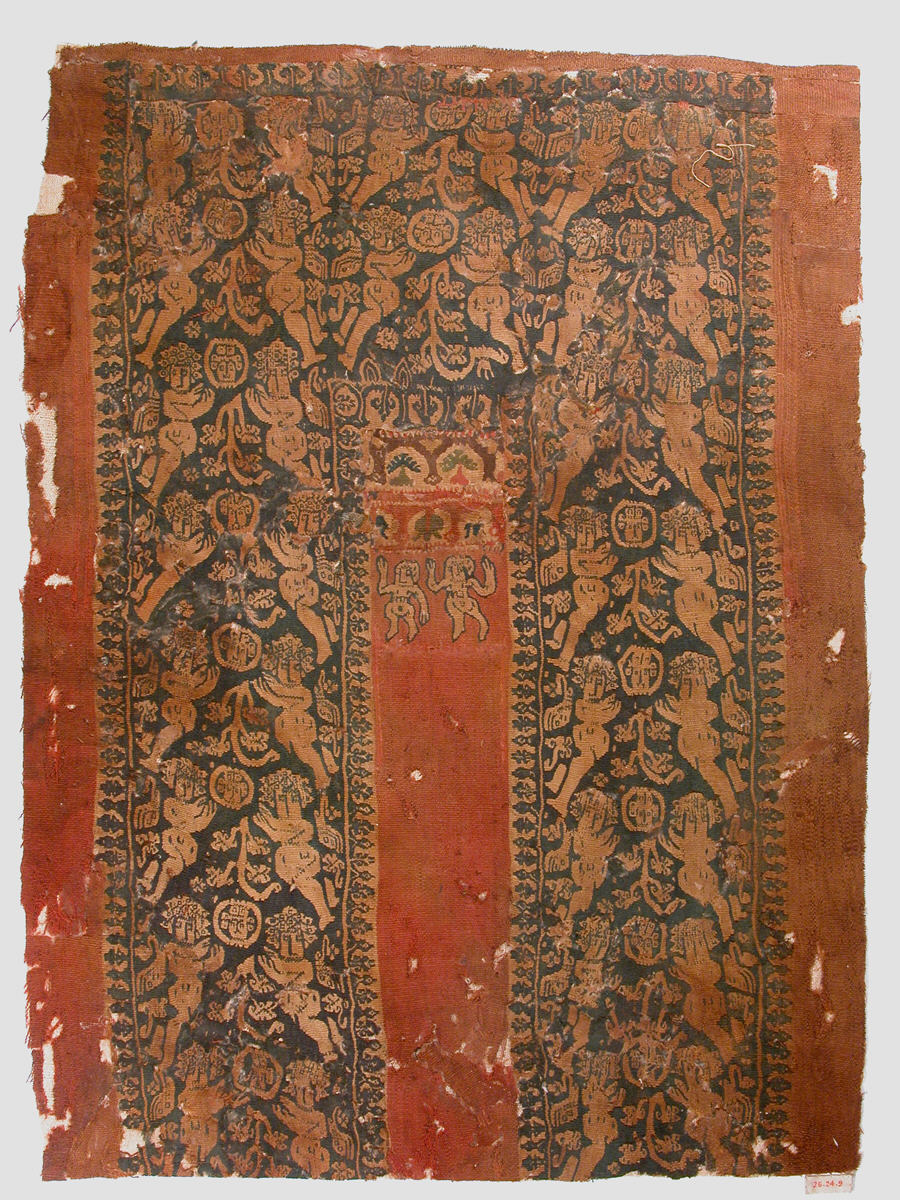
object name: tunic fragment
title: Fragment of a Tunic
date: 301-400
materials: wool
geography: egypt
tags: human figures